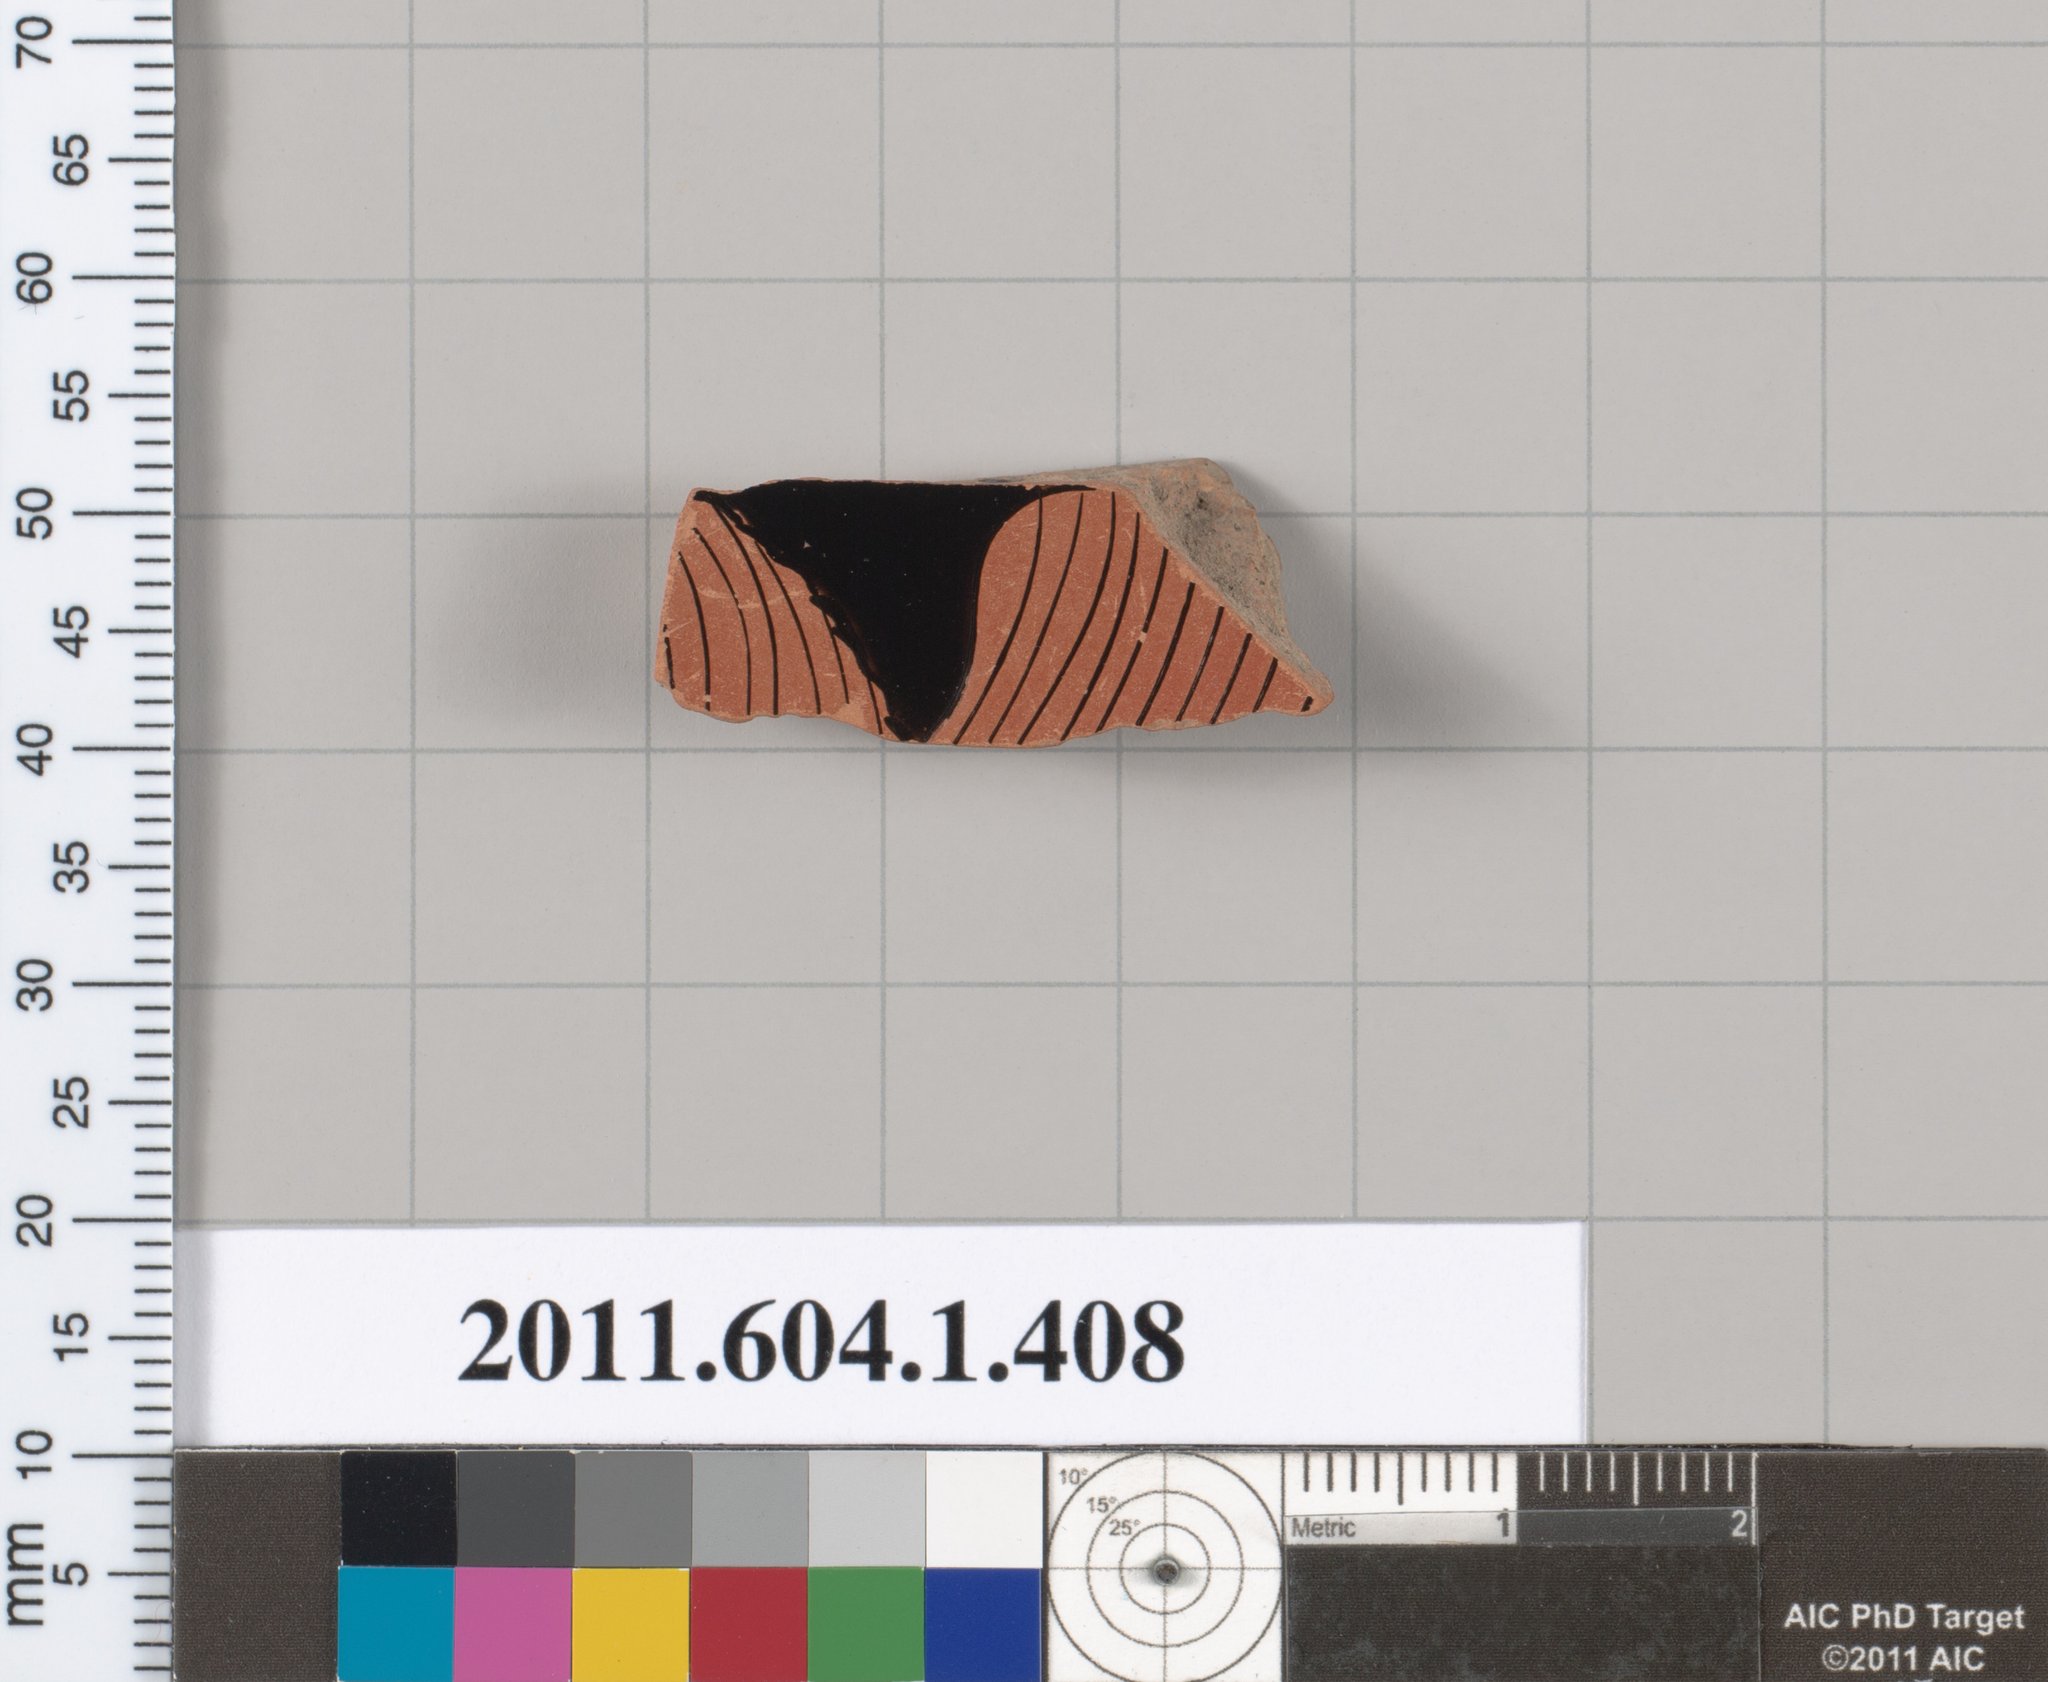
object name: kylix fragment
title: Terracotta fragment of a kylix (drinking cup)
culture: greek, attic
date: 475-451 BCE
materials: terracotta